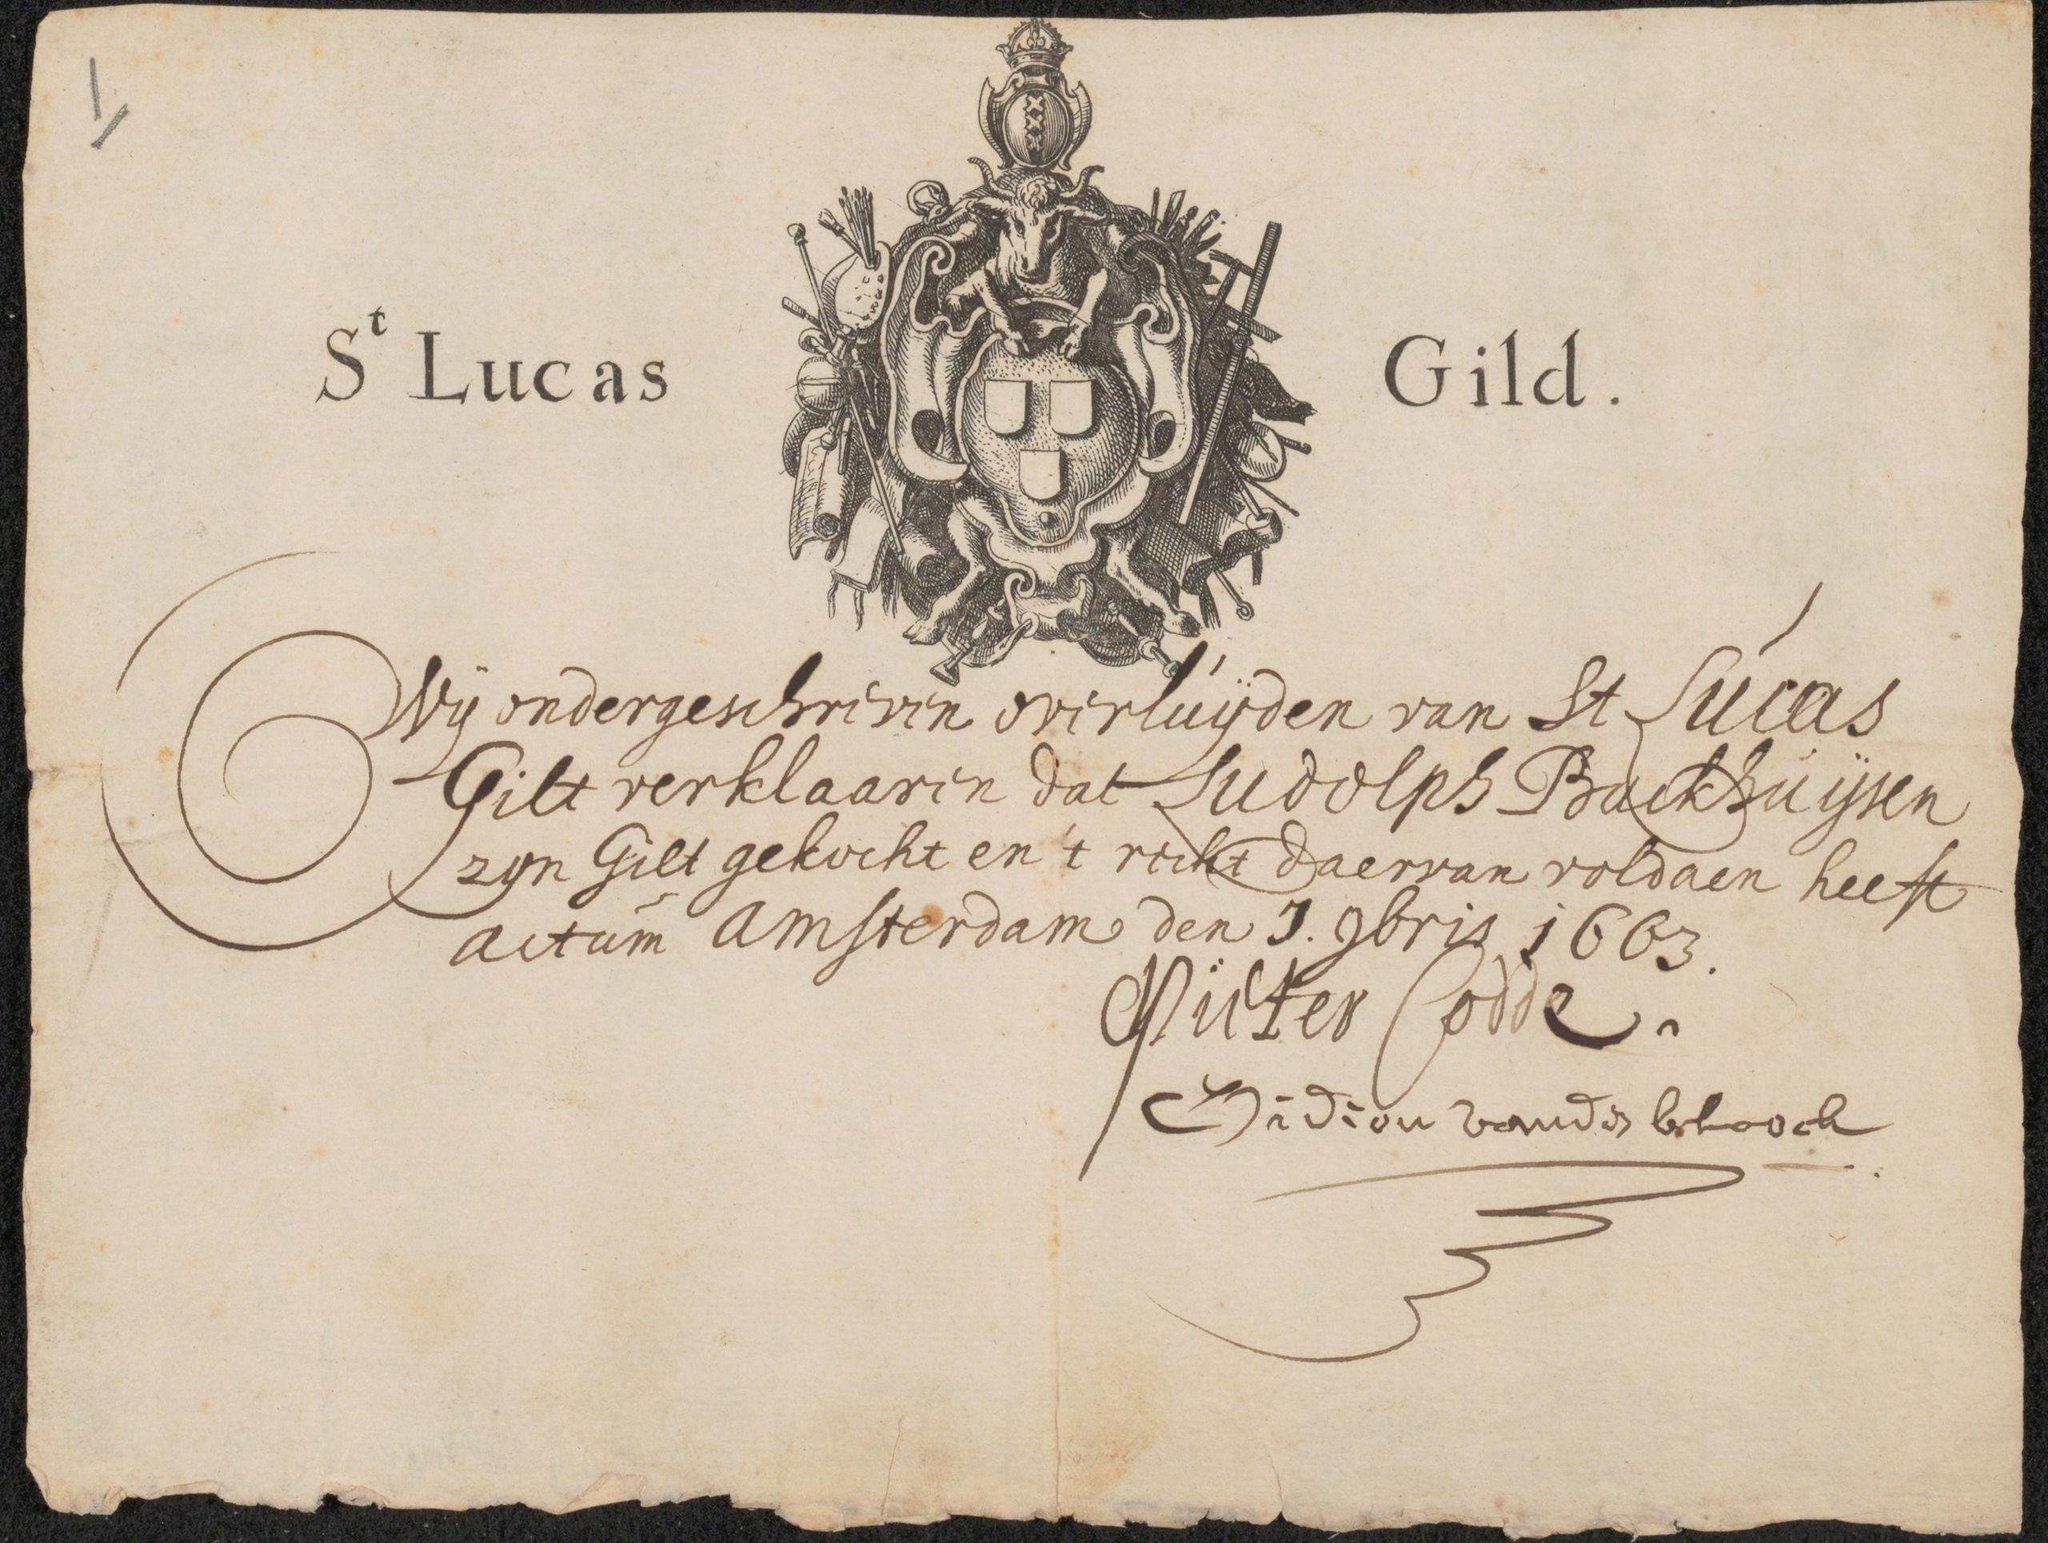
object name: membership certificate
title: Lidmaatschapsbewijs van Ludolf Bakhuysen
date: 1663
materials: ink, paper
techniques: pen, printing, writing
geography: amsterdam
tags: amsterdam, print maker, draughtsman, ludolf bakhuysen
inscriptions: collector's mark: Lugt 2233